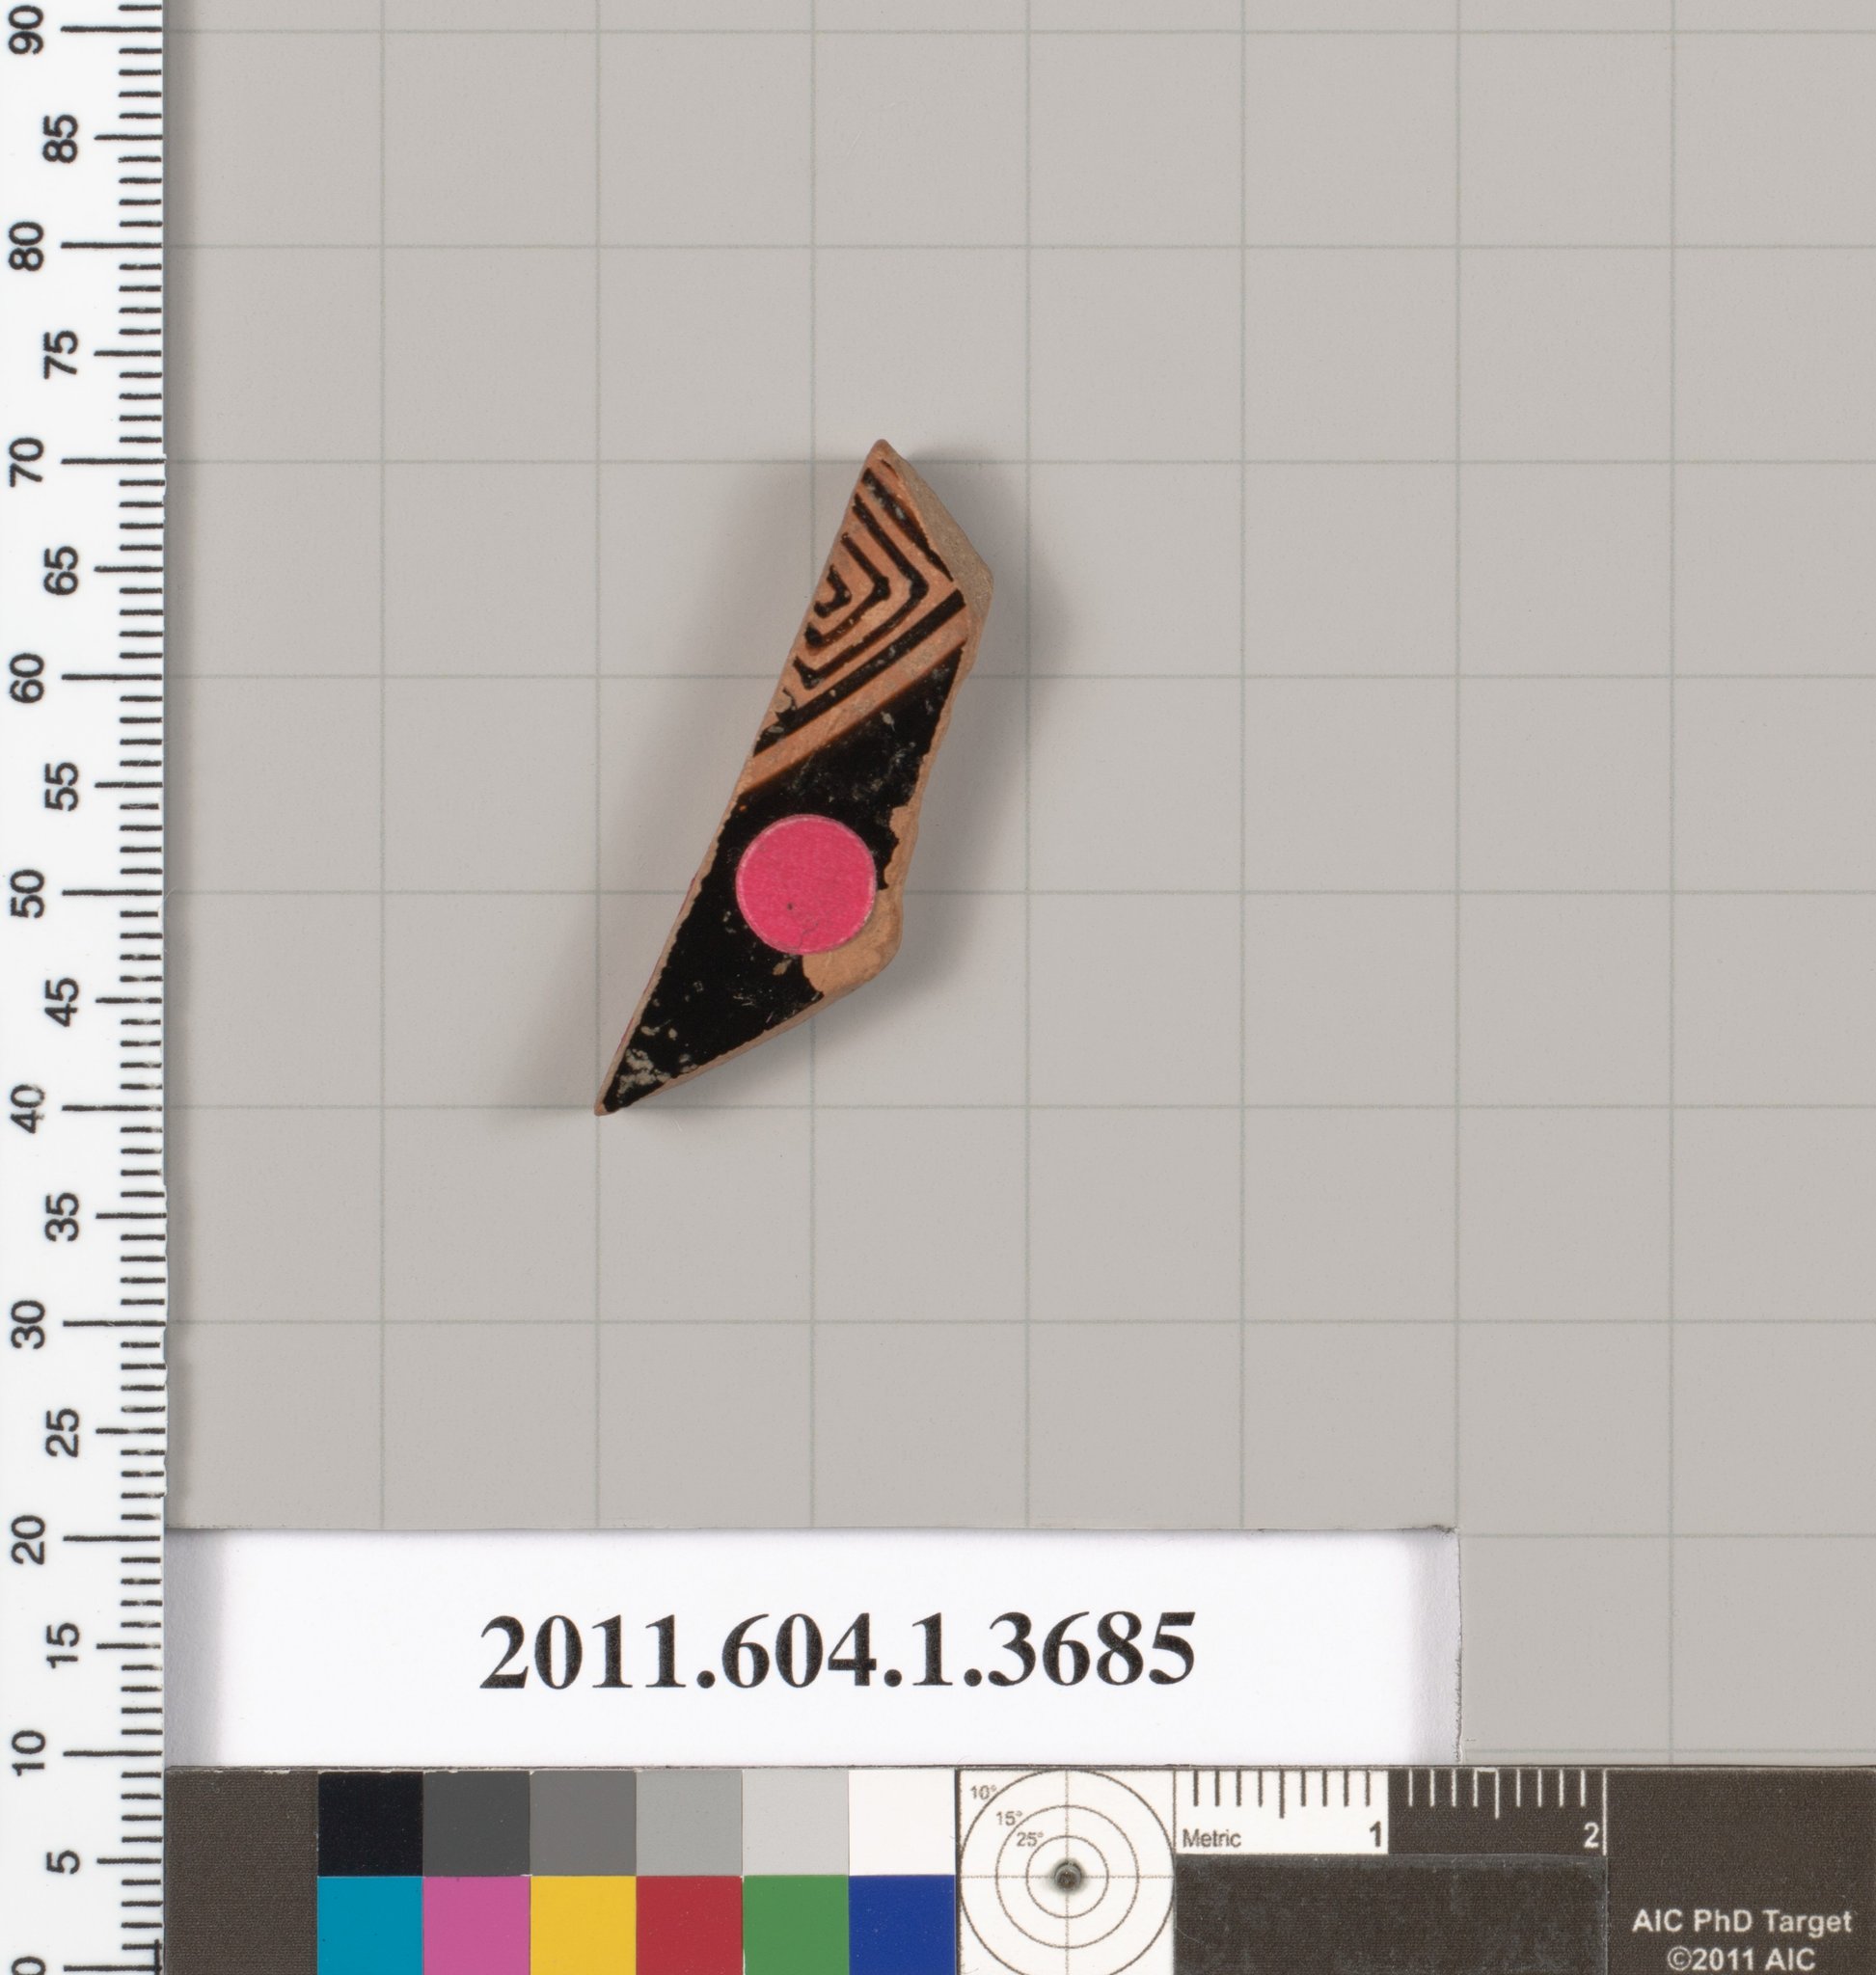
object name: kylix fragment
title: Terracotta fragment of a kylix (drinking cup)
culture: greek, attic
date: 475-451 BCE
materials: terracotta